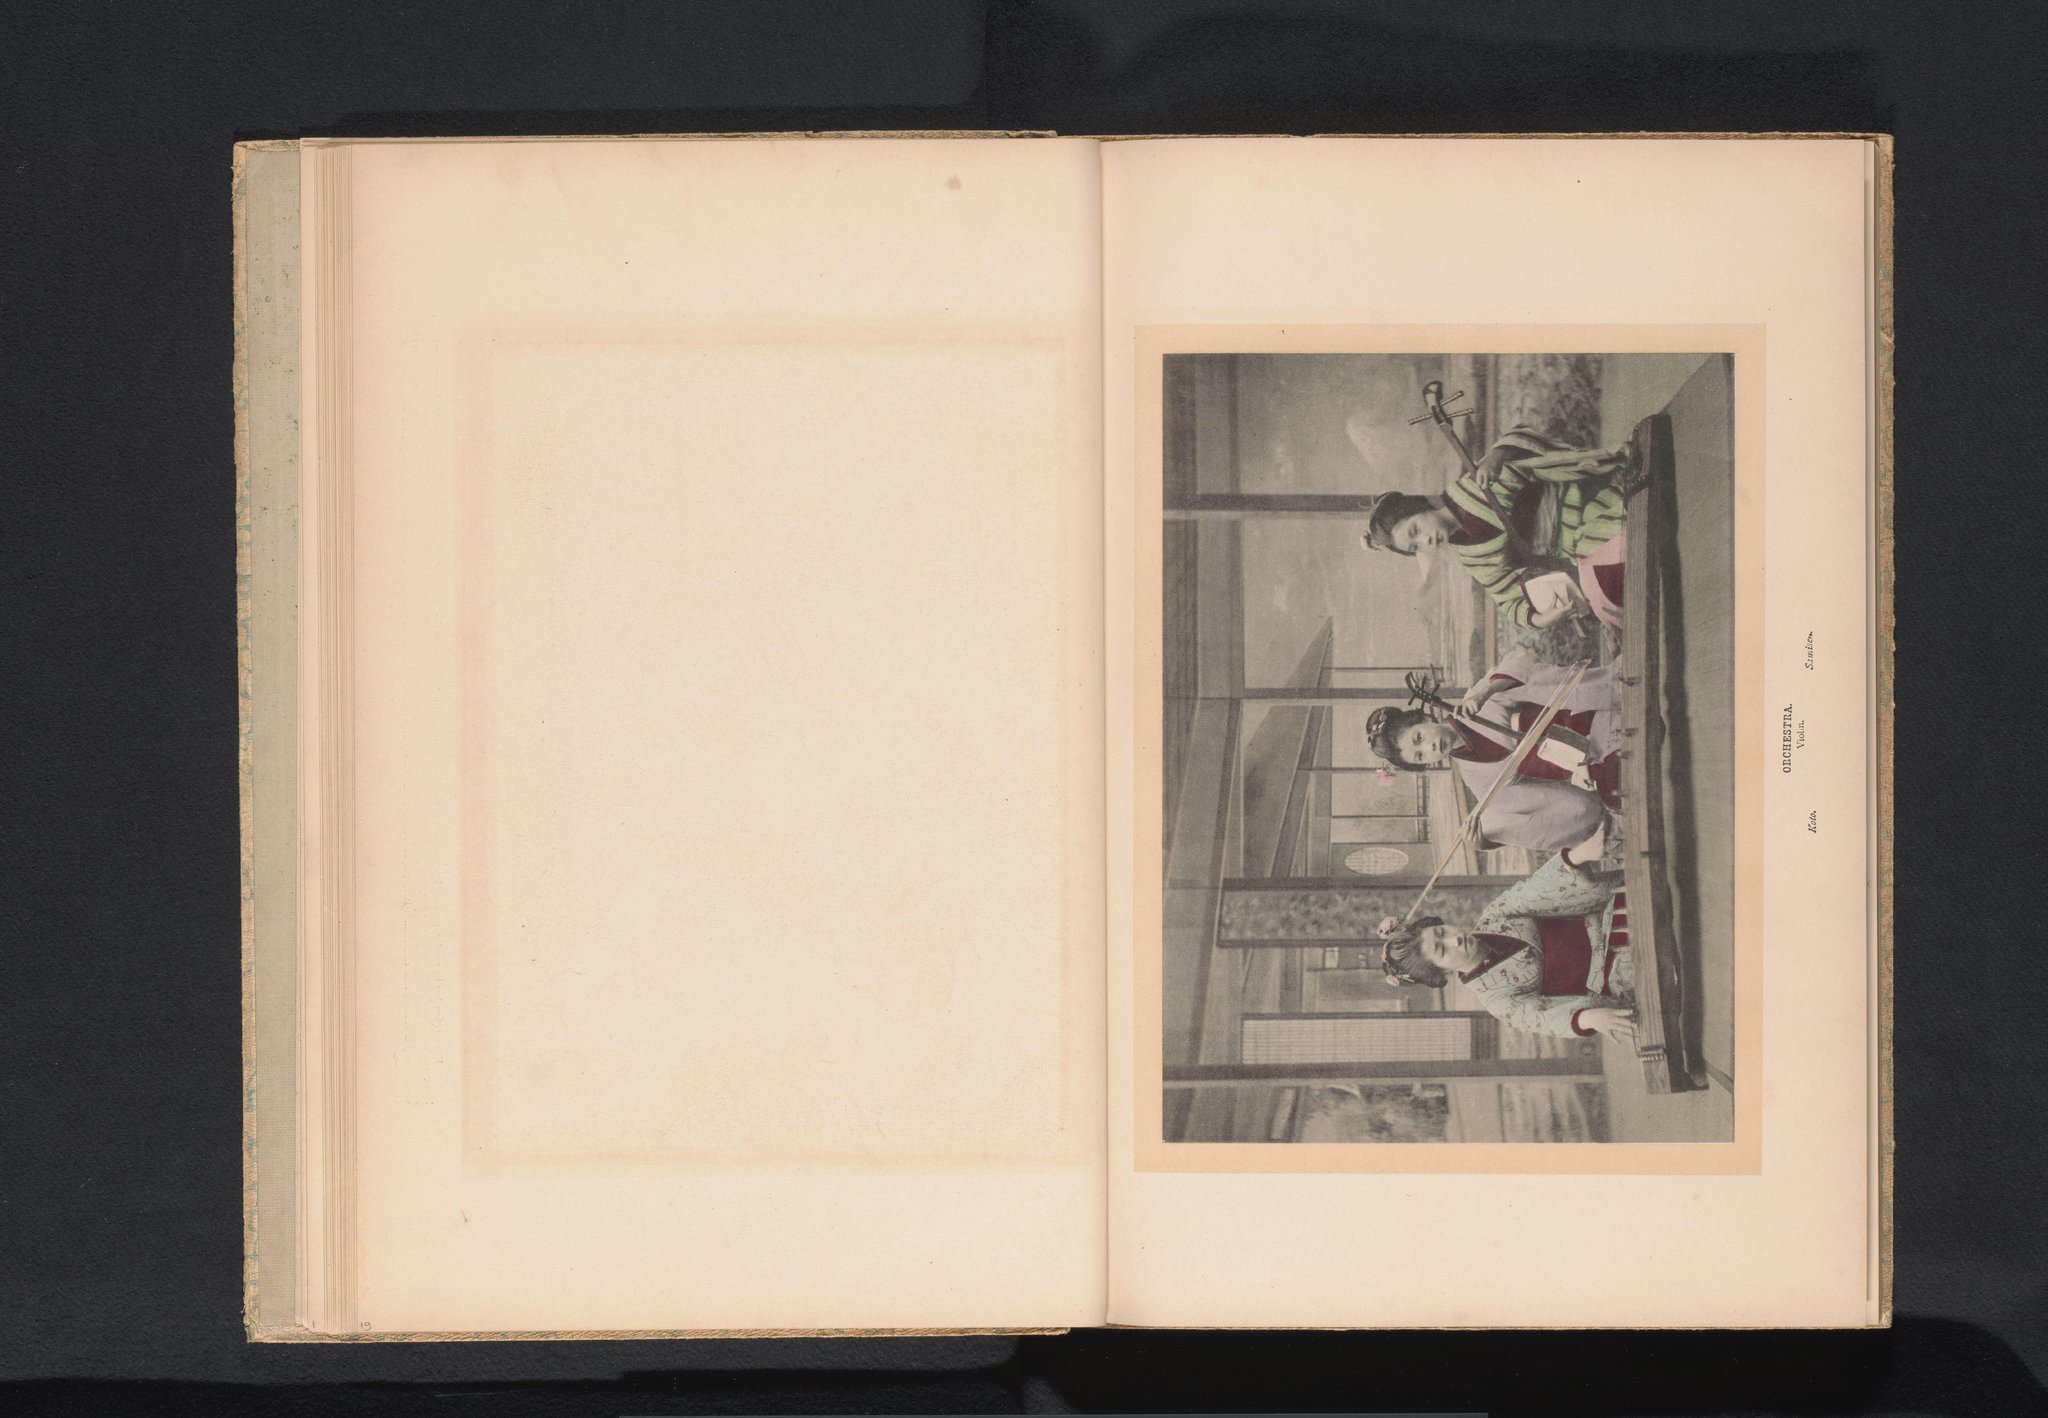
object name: photomechanical print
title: Orchestra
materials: paper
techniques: photograph, lithograph, hand coloring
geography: japan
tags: small group of musicians, chamber orchestra, jazz band, adult woman (+ three persons), japan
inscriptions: inscription: ‘Kota Violin Samisen.’